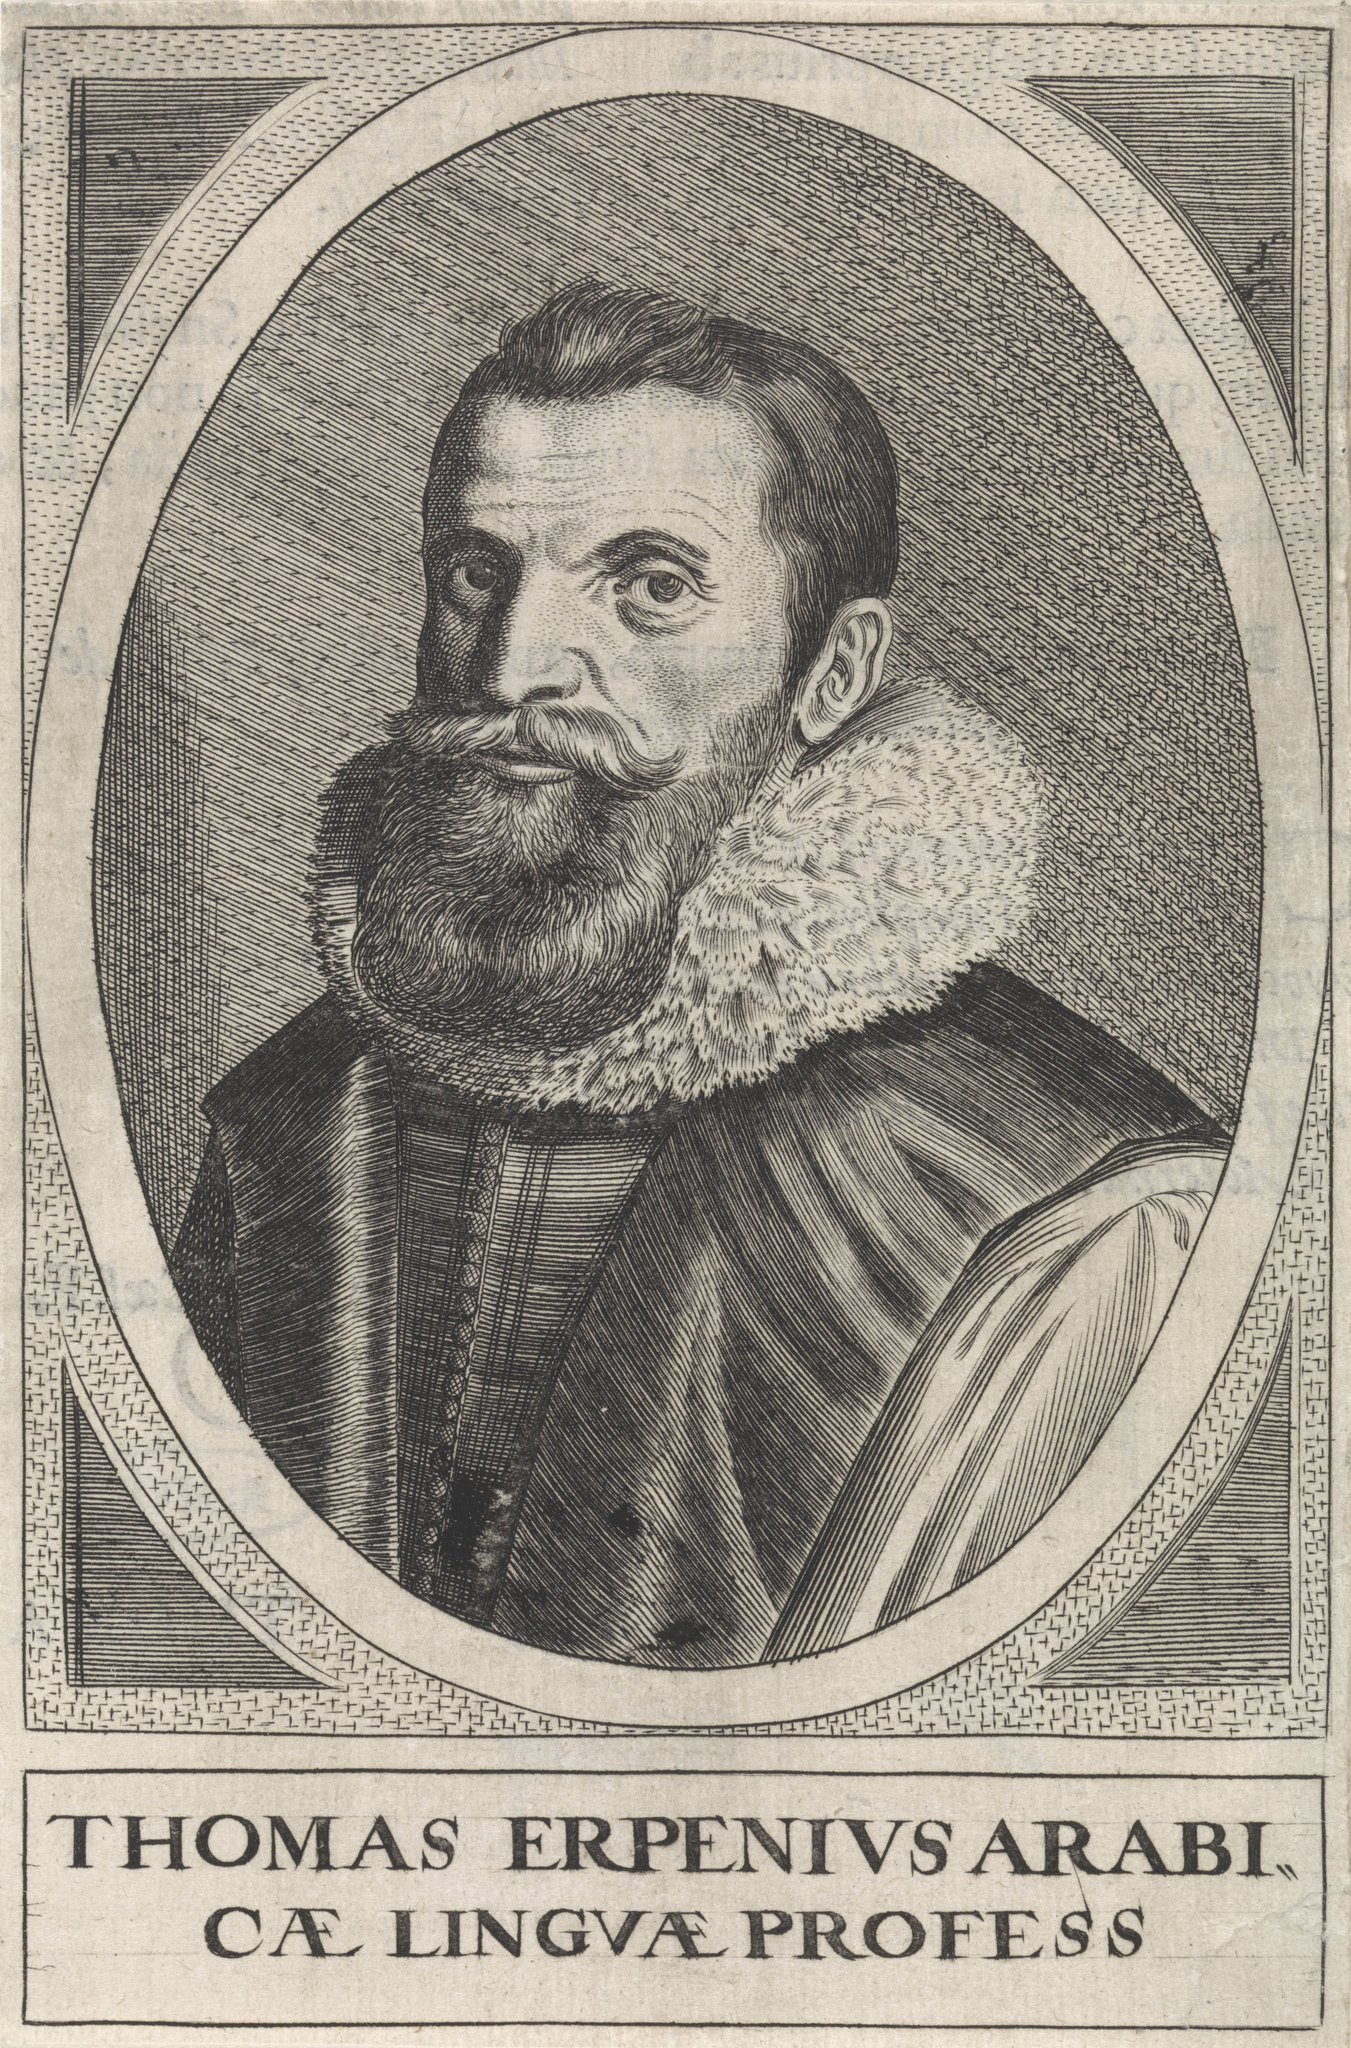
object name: print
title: Portret van Thomas Erpenius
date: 1625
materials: paper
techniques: engraving, letterpress printing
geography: leiden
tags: leiden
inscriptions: collector's mark: Lugt 964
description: Boekillustratie in: Meursius, Joannes. Athenæ Batavæ. Sive, De vrbe Leidensi, & academiâ, virisque claris. Leiden: Andries Clouck, Bonaventura en Abraham Elzevier, 1625. Abusievelijk tweemaal gecatalogiseerd bij Franken & Van der Kellen.